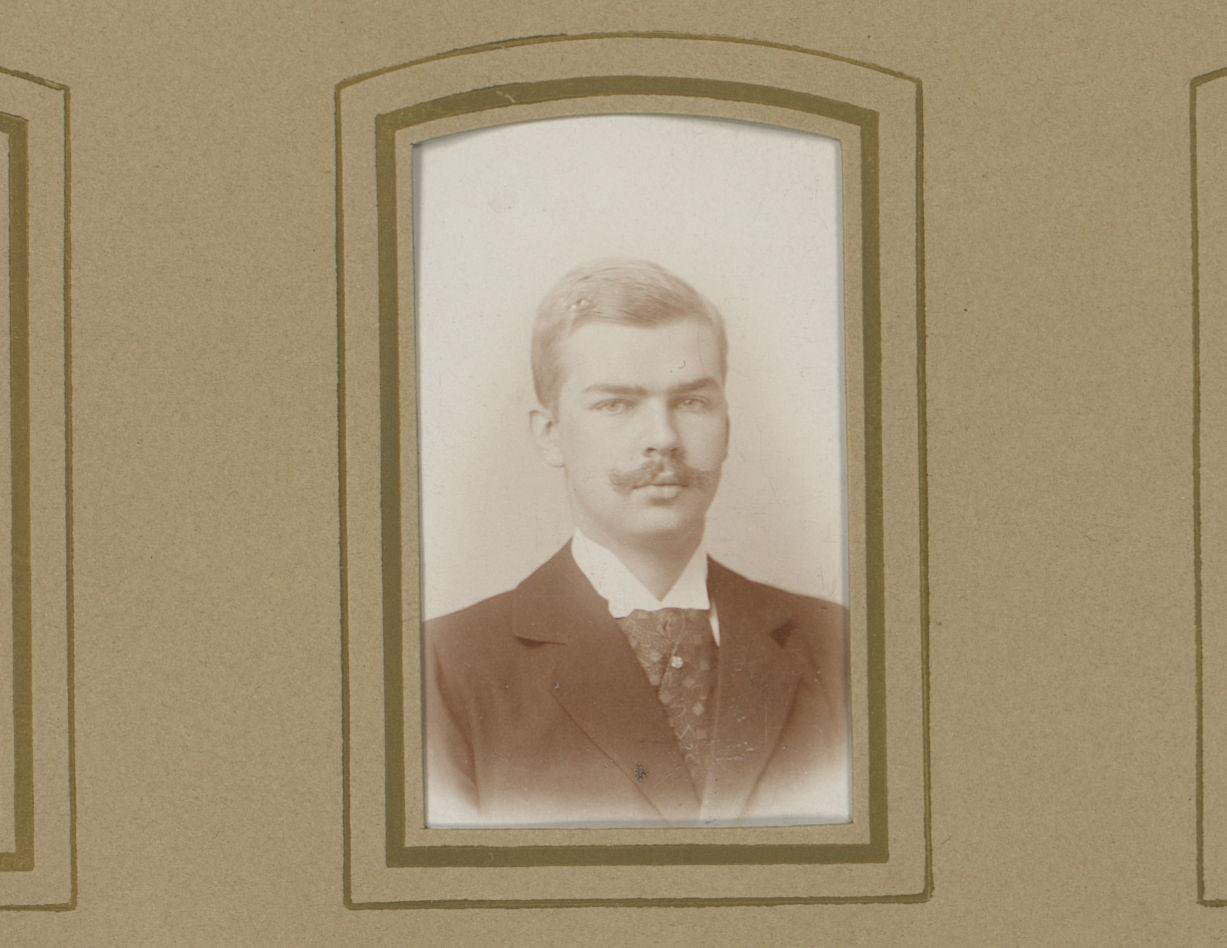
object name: carte de visite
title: Portret van een man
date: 1880-1903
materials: cardboard, photographic support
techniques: collodion silver print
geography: the hague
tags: historical persons